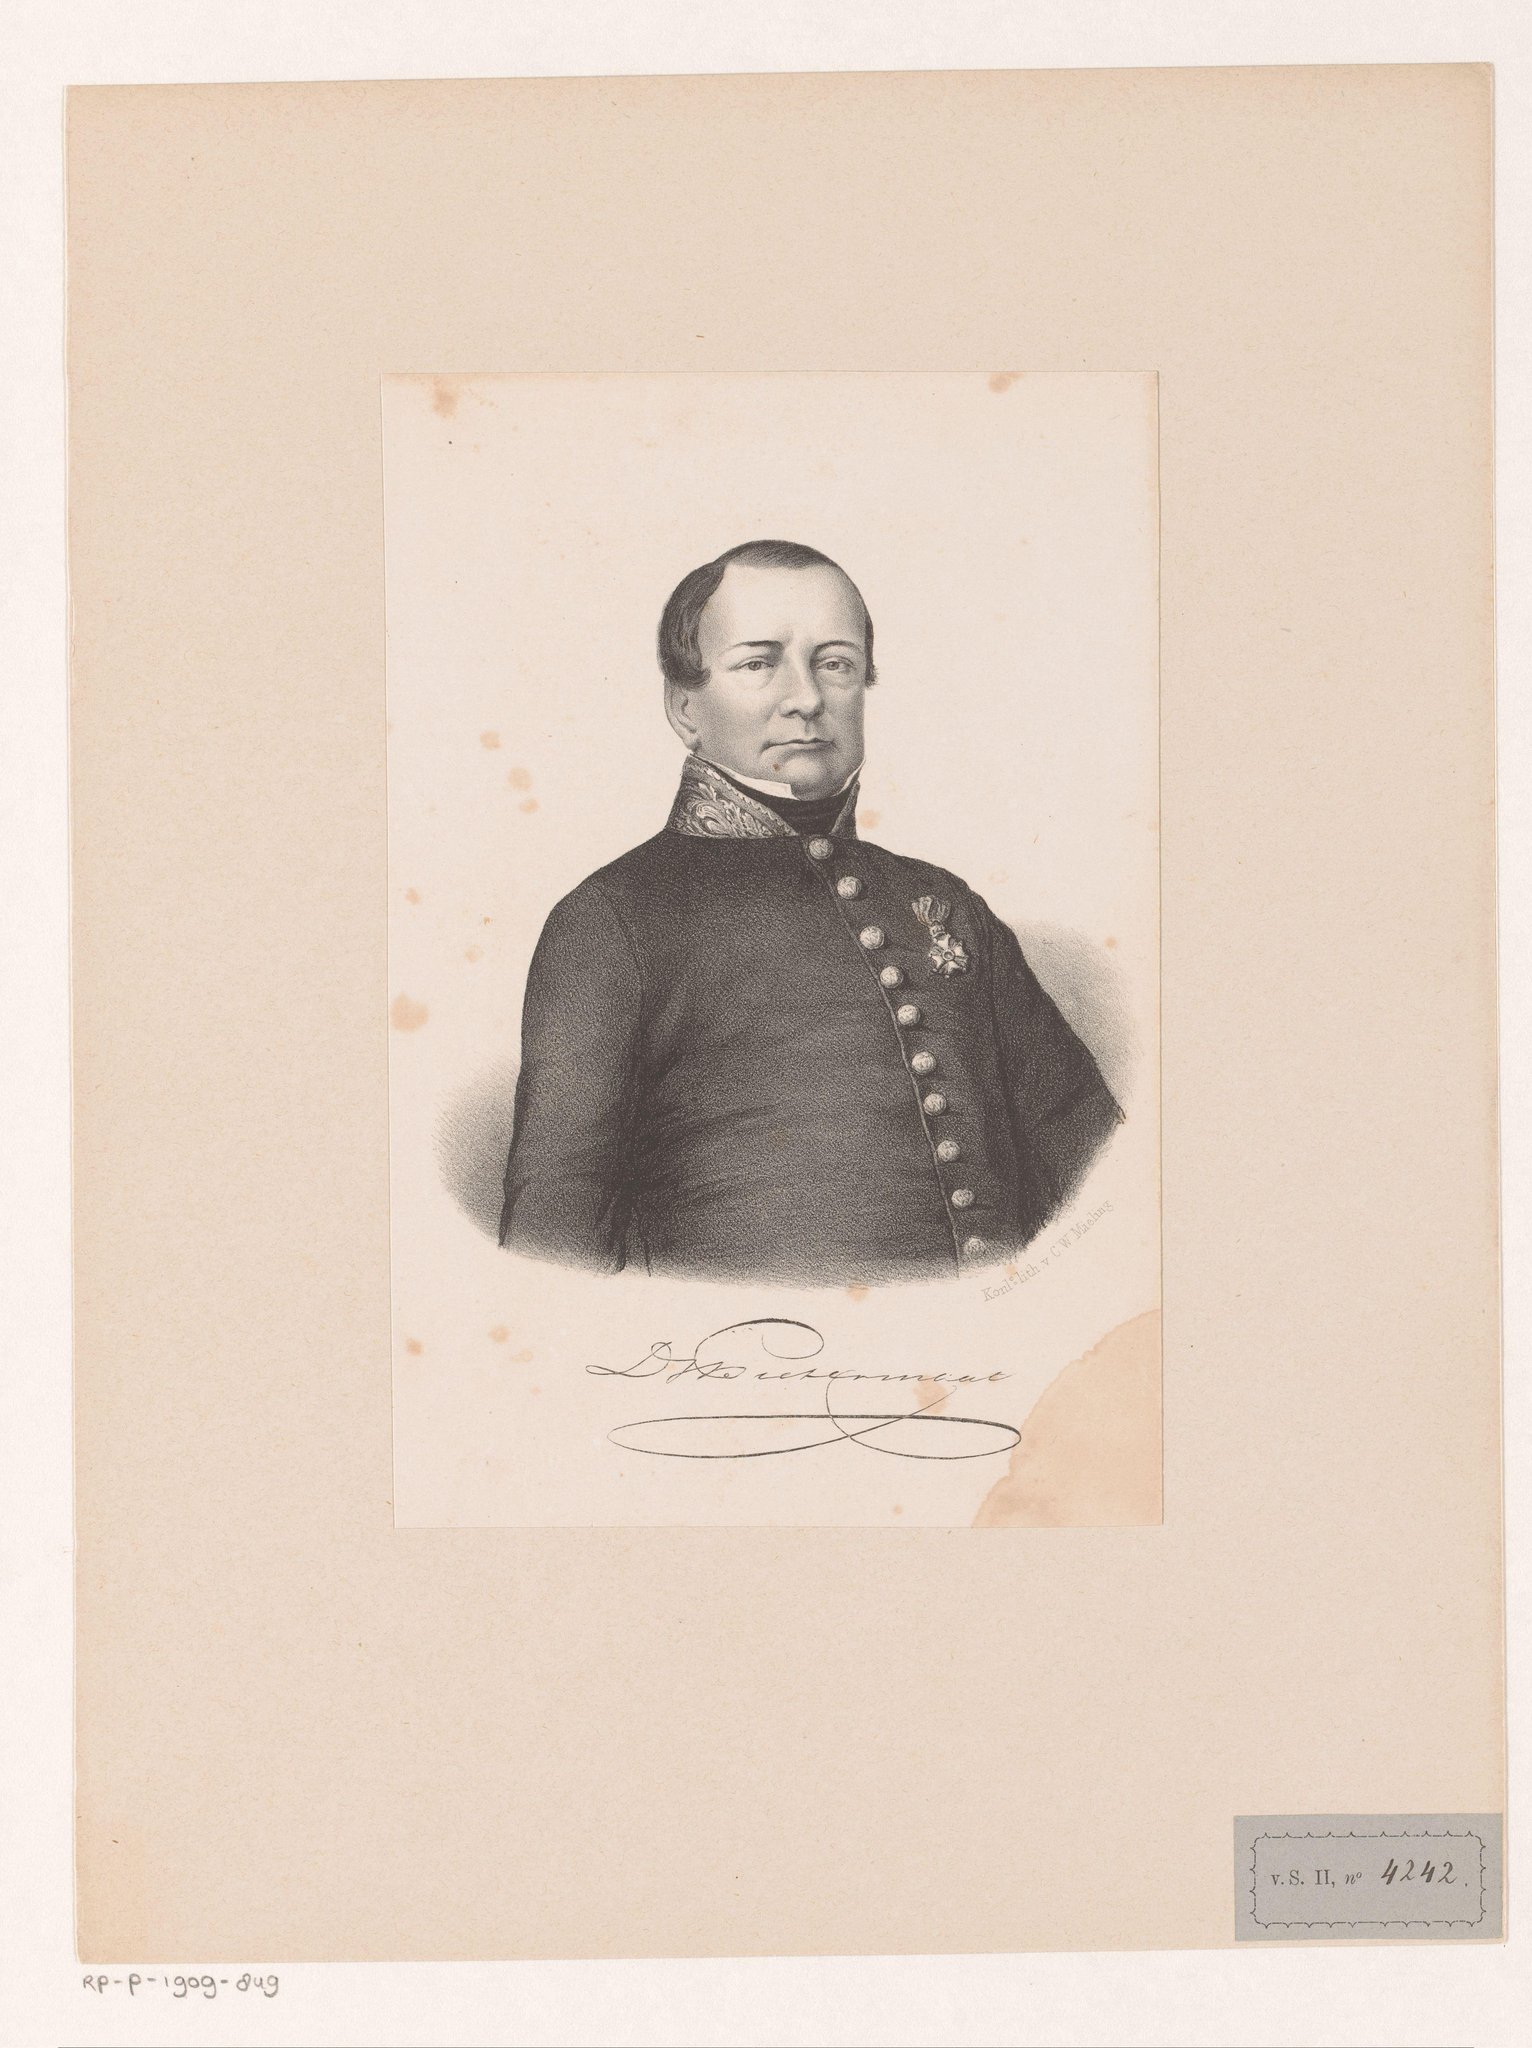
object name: print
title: Portret van Daniël François Willem Pietermaat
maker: Anonymous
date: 1847-1865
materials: paper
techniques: lithograph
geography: the hague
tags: knighthood order, historical persons (+ (full) bust portrait)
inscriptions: collector's mark: Lugt 2228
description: De geportretteerde draagt een ridderorde op zijn borst. Onder het portret zijn signatuur.